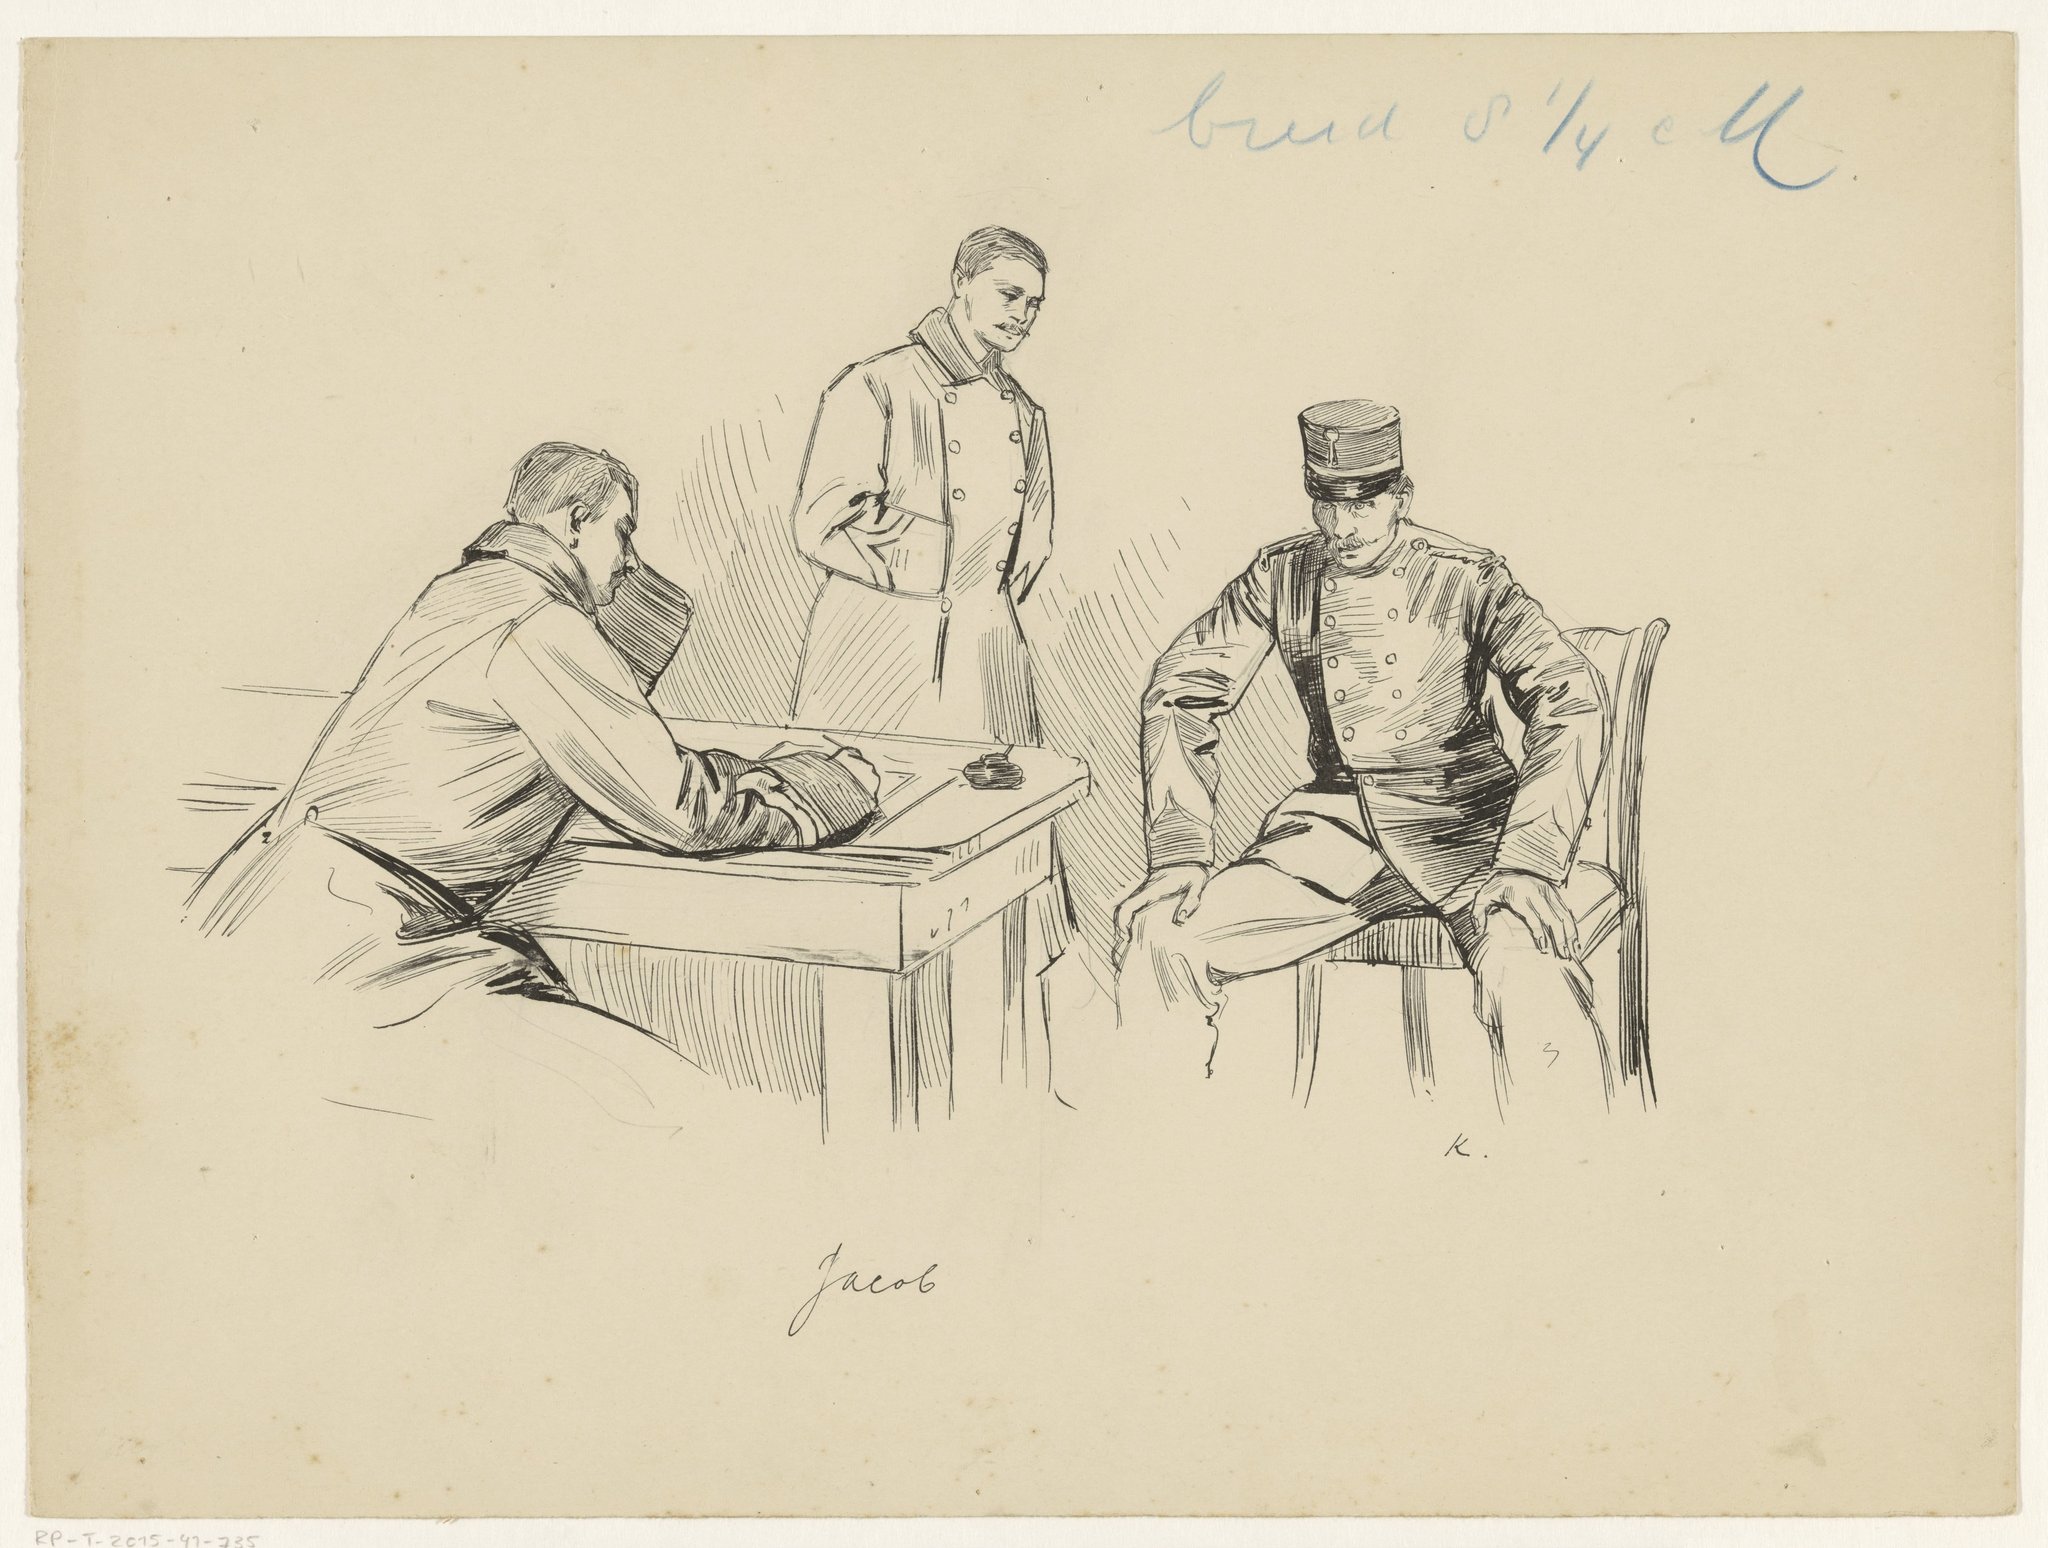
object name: drawing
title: Drie mannen rond een tafel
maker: heinrich m. krabbé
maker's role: draughtsman, print maker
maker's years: 1868-1931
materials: ink, paper, pencil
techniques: pen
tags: table, writing accessories, (military) uniforms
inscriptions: signature: ‘K.’, collector's mark: Lugt 2228, :, annotation: ‘Jacob’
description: Twee mannen, onder wie een man in militair uniform, zitten rond een tafel. Eén van hen schrijft iets op een vel papier. In de achtergrond staat een derde man met de handen in de zakken.